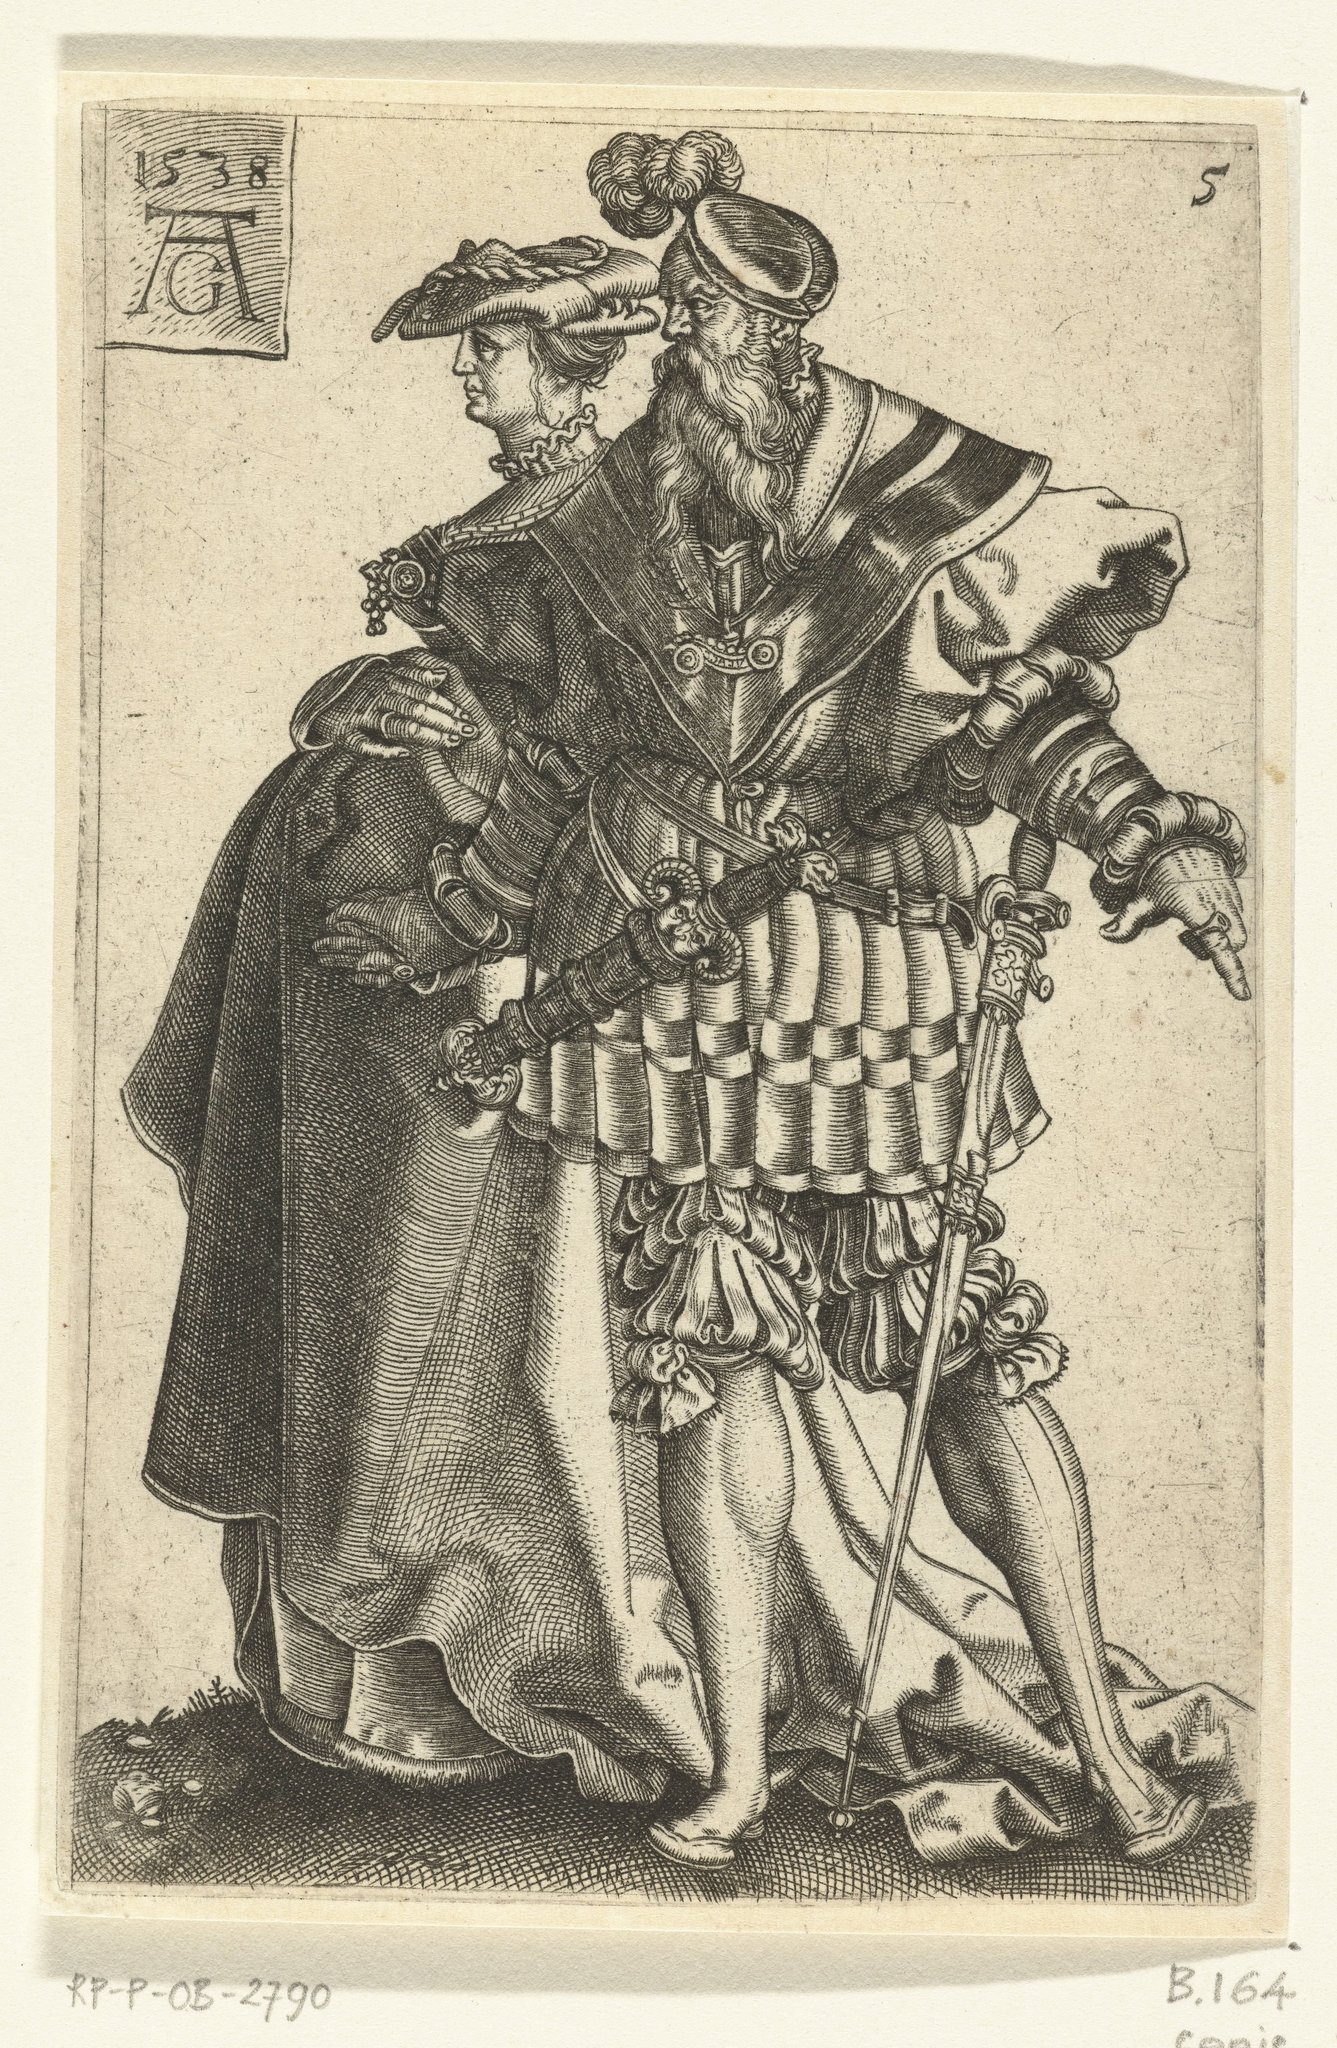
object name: print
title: Dansend paar no. 5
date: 1538-1610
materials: paper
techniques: engraving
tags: dancing at wedding feast, one pair dancing; man and woman dancing as a couple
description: Datering Duitse kleding: 1530-1540. Man: korte tabbaard met passement. Kniebroek met strik op knie. Koemuilen.